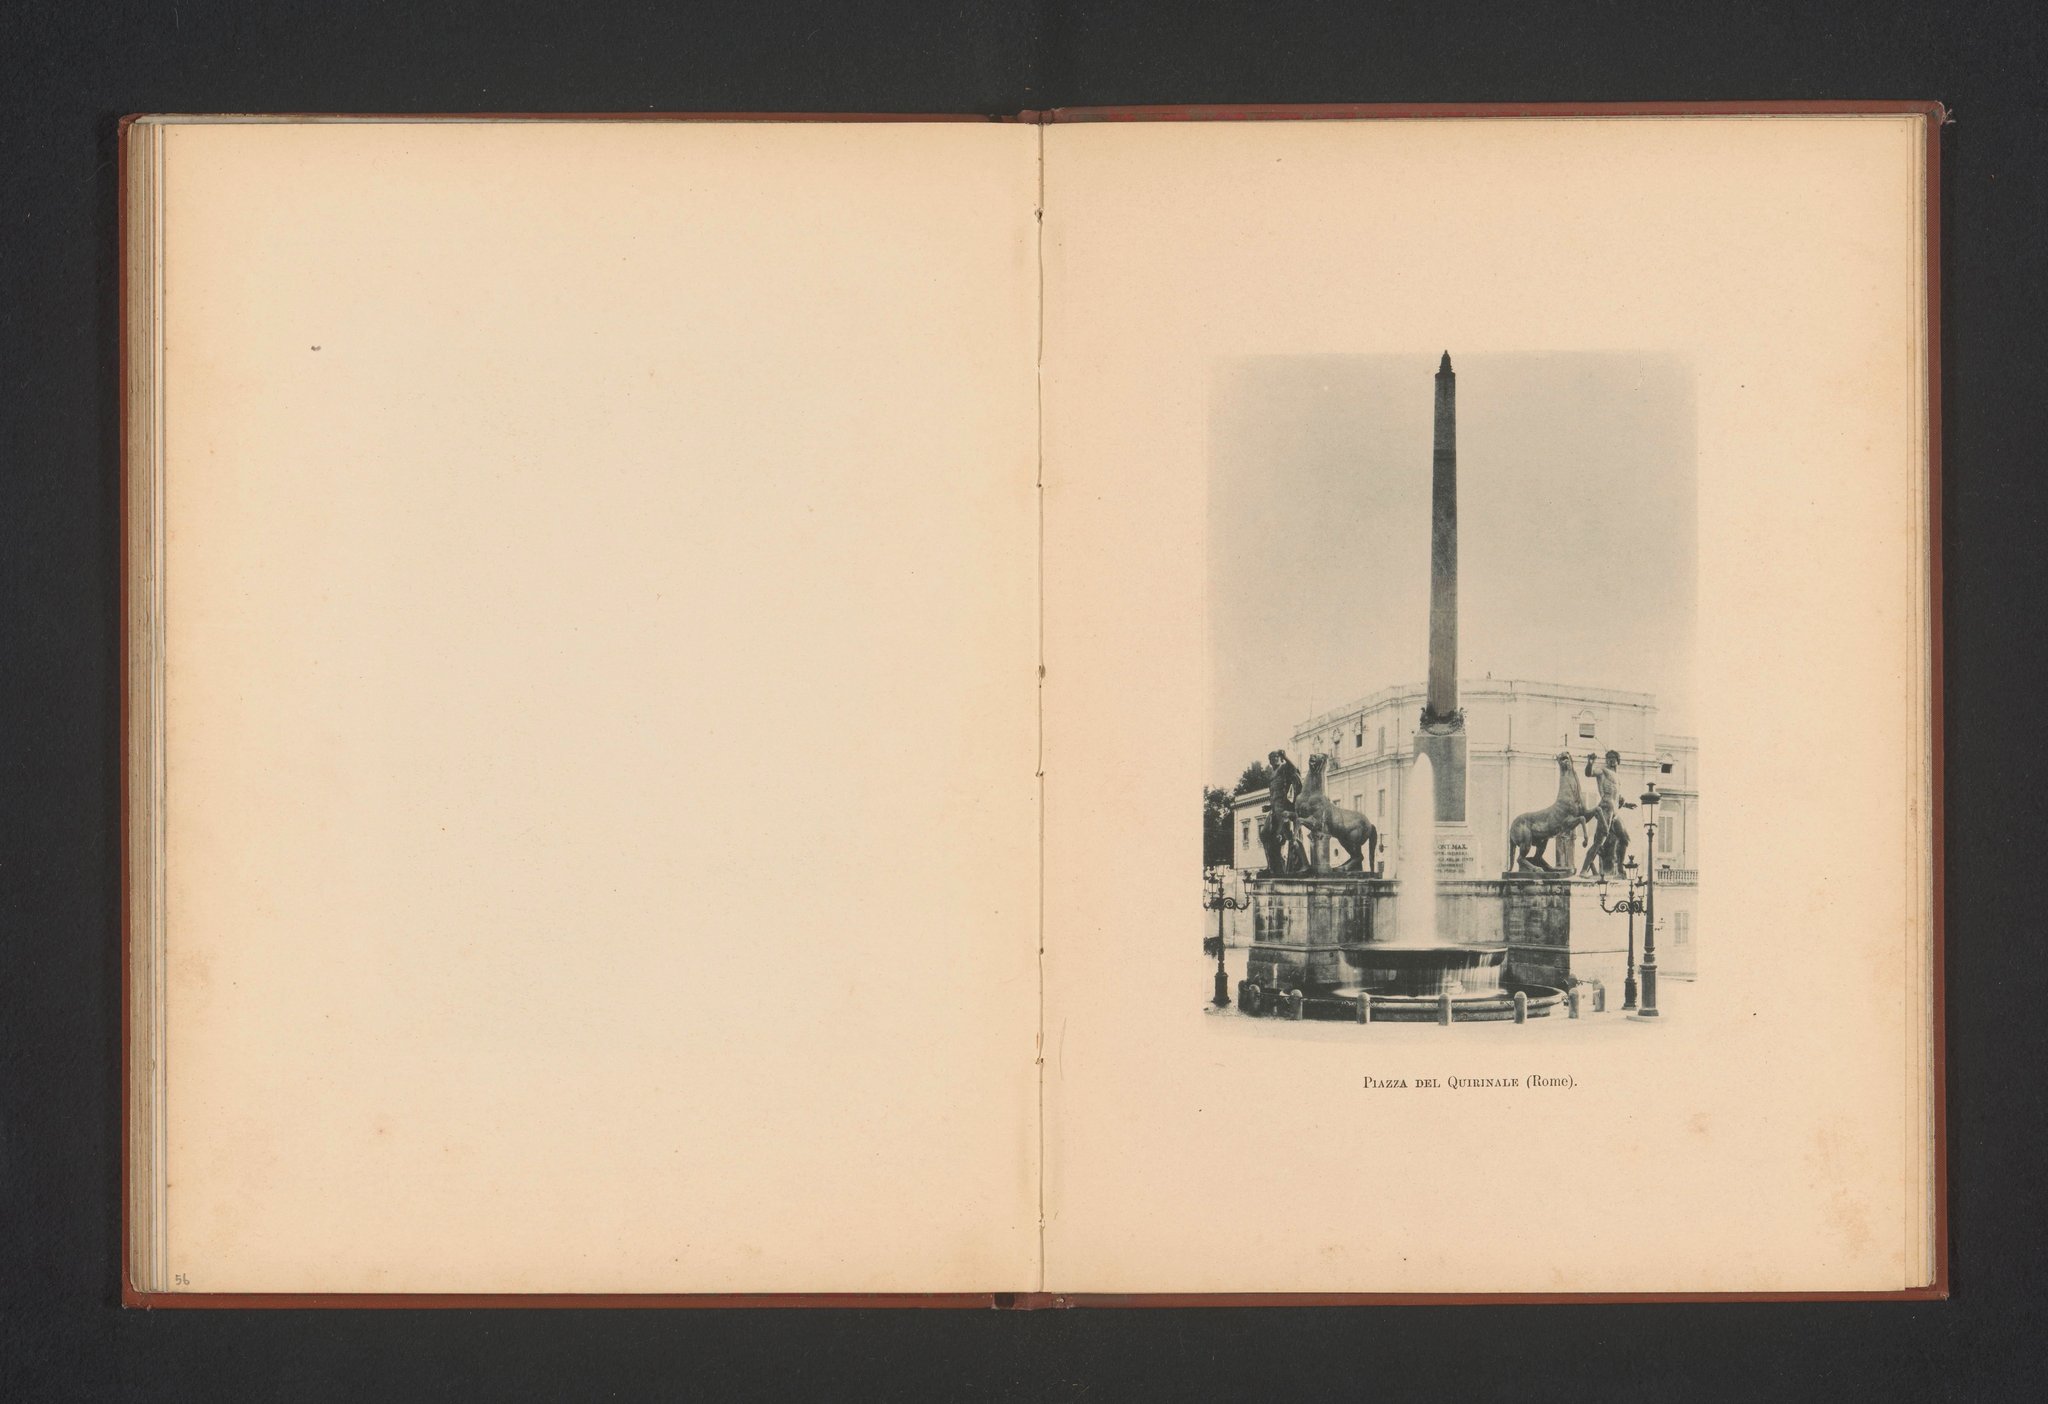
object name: page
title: Gezicht op het Piazza del Quirinale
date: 1893-1898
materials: paper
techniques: photograph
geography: piazza del quirinale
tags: column, pillar ~ architecture, palace